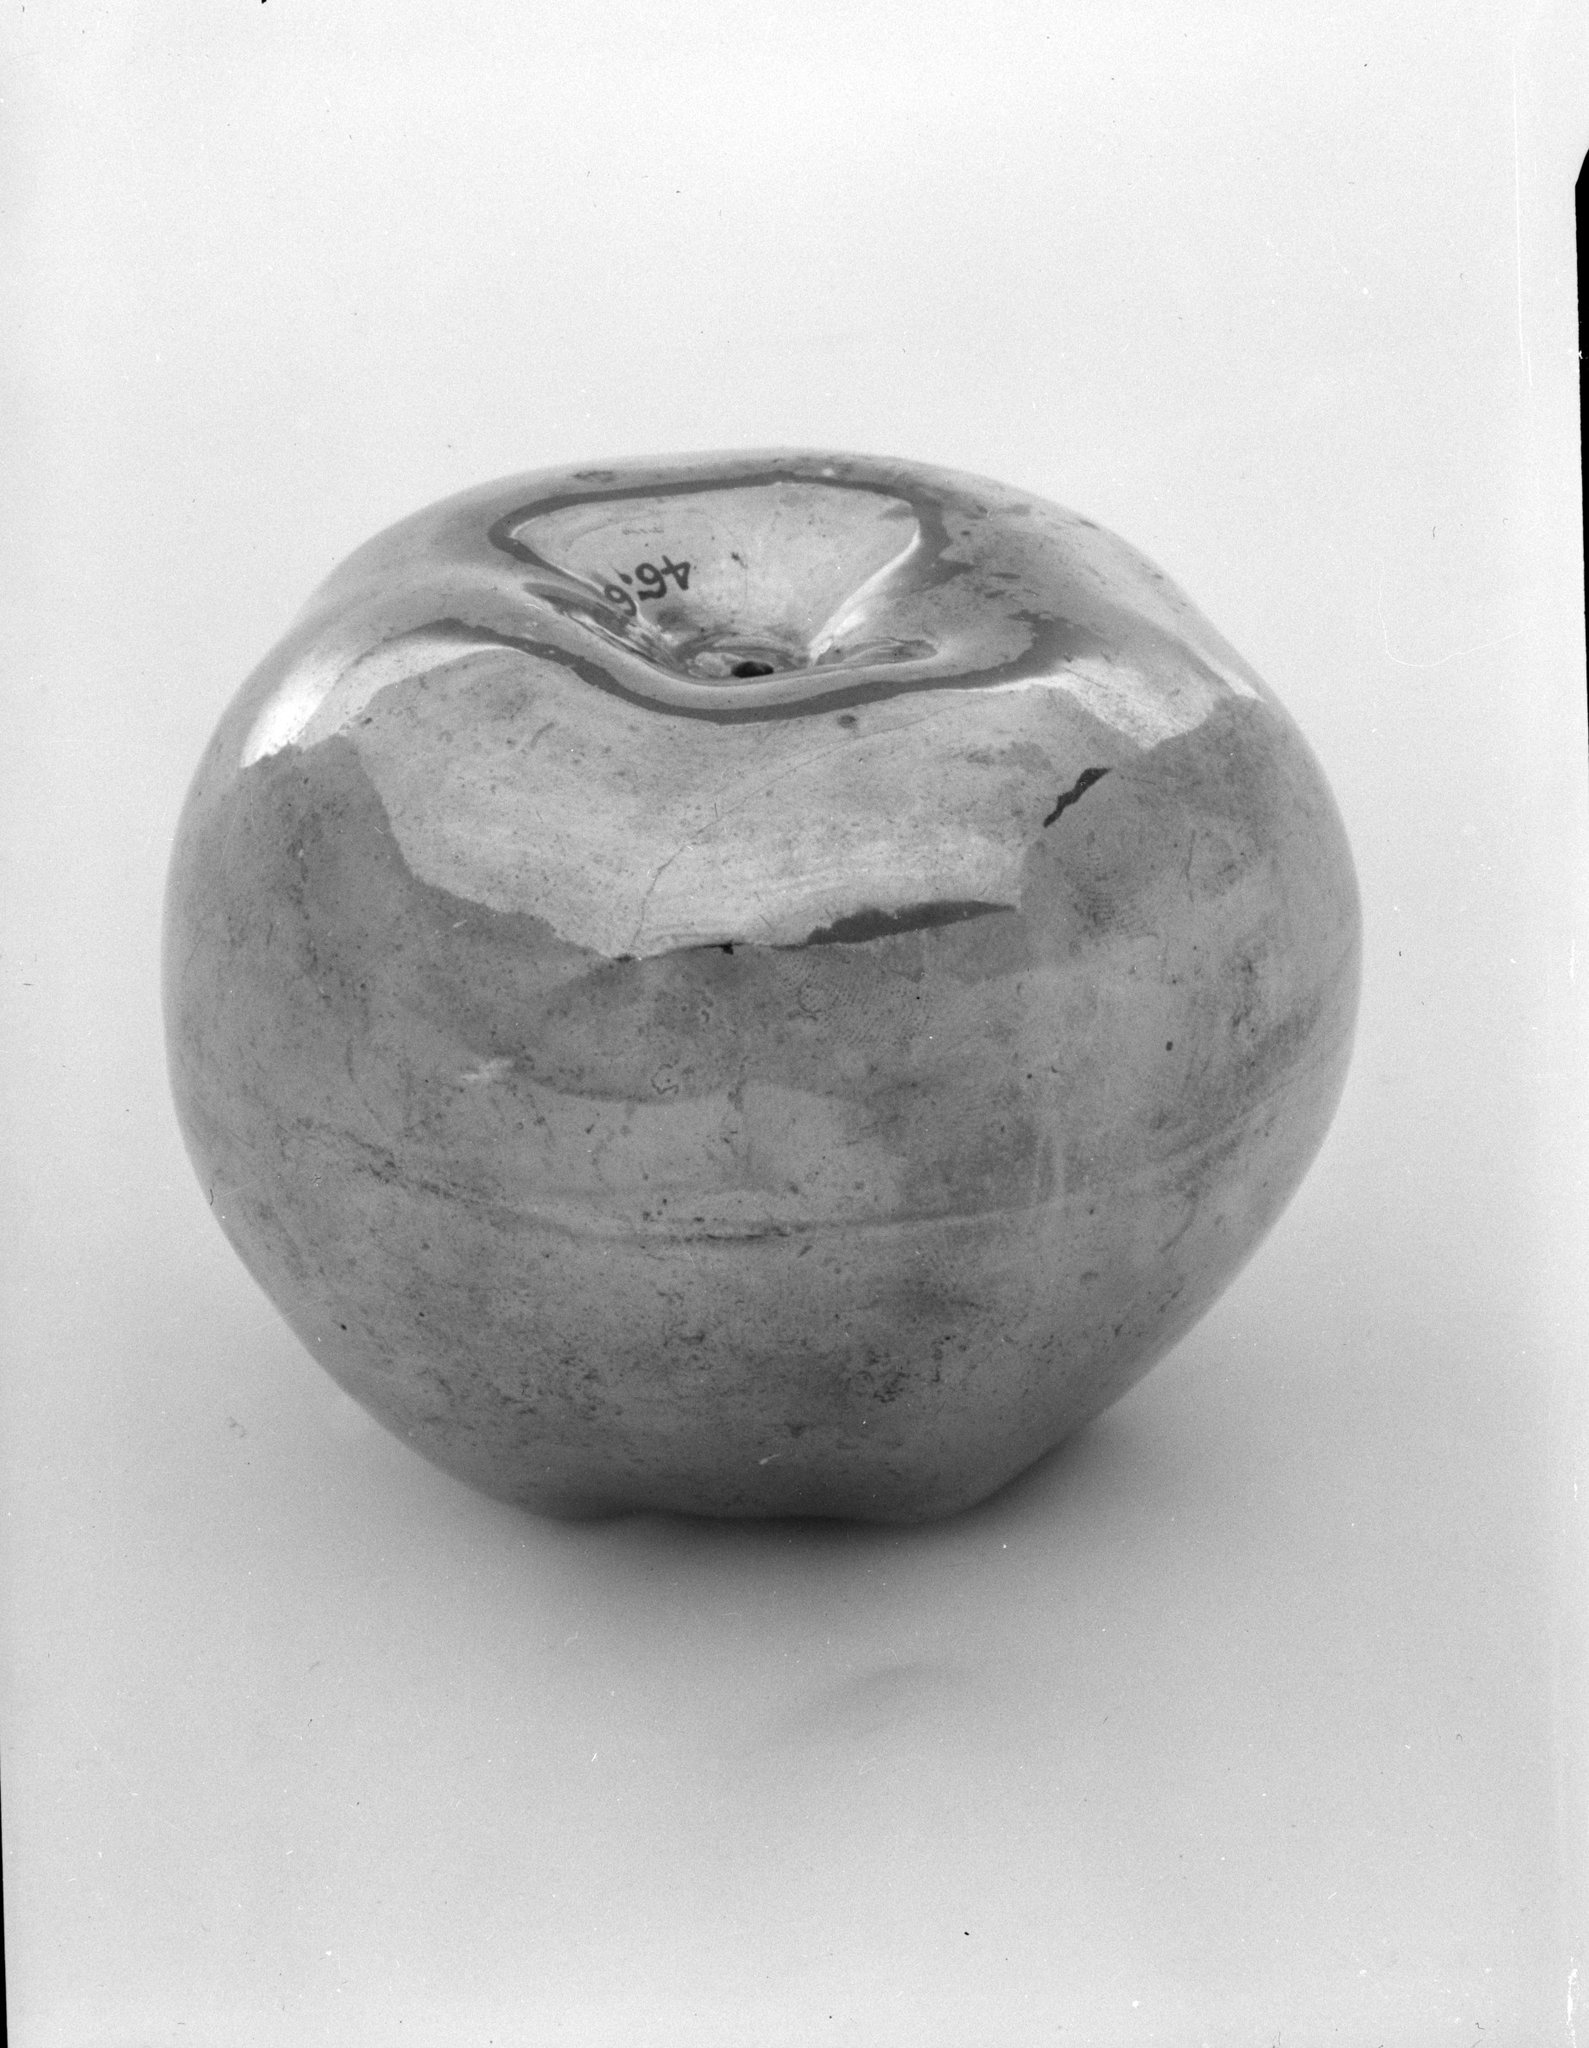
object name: figure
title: Figure of an Apple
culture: british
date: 1800-1830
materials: earthenware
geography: england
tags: apples